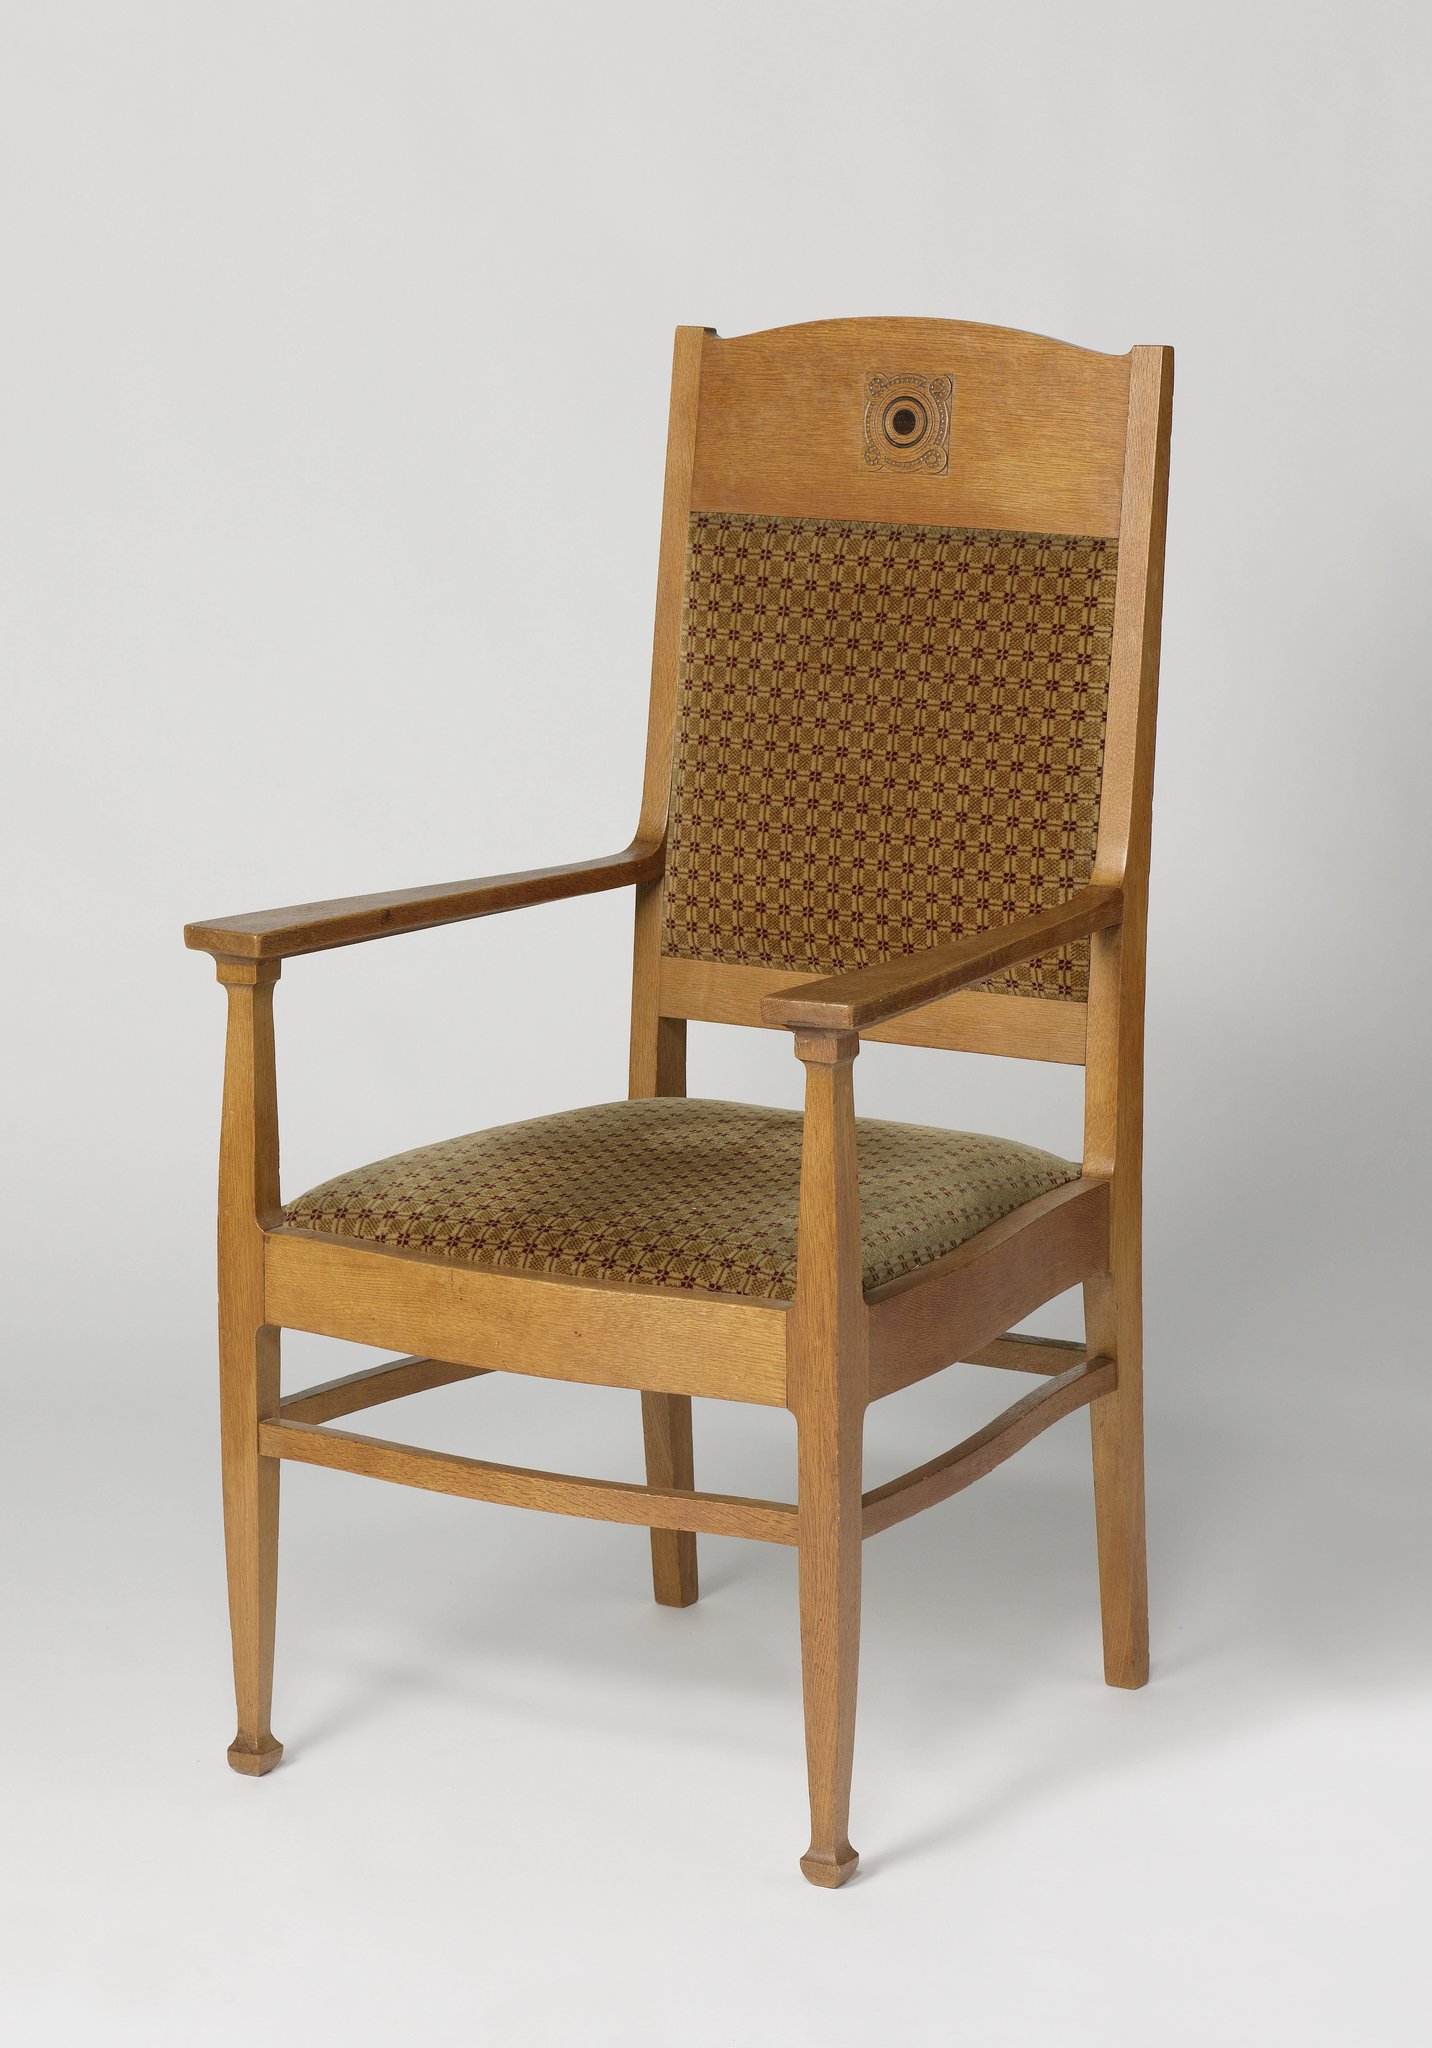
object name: armchair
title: Armstoel met een gesneden gevlochten rozet en bekleed met groene trijp met rode ruitmotieven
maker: karel petrus cornelis de bazel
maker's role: draughtsman, print maker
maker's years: 1869-1923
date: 1894-1900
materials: wood, wool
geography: netherlands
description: Armstoel van eikenhout rustend op vier gebogen poten. De poten zijn onderling verbonden door middel van gebogen regels. De voorpoten lopen door in de stutten voor de armleggers. De achterpoten lopen door in de rugstijlen. De rugleuning bestaat uit een paneel met geronde bovenkant aan de bovenzijde en een regel aan de onderzijde. De open ruimte daartussen is bekleed met groene trijp met rode ruitmotieven. Op het paneel aan de bovenzijde is in het midden een gesneden gevlochten rozet met parelranden en ingelegd met ebbenhout. De armleggers verbreden naar de voorzijde. De zitting is trapeziumvormig en is bekleed met hetzelfde groene trijp met rode ruitmotieven als op de rugleuning.